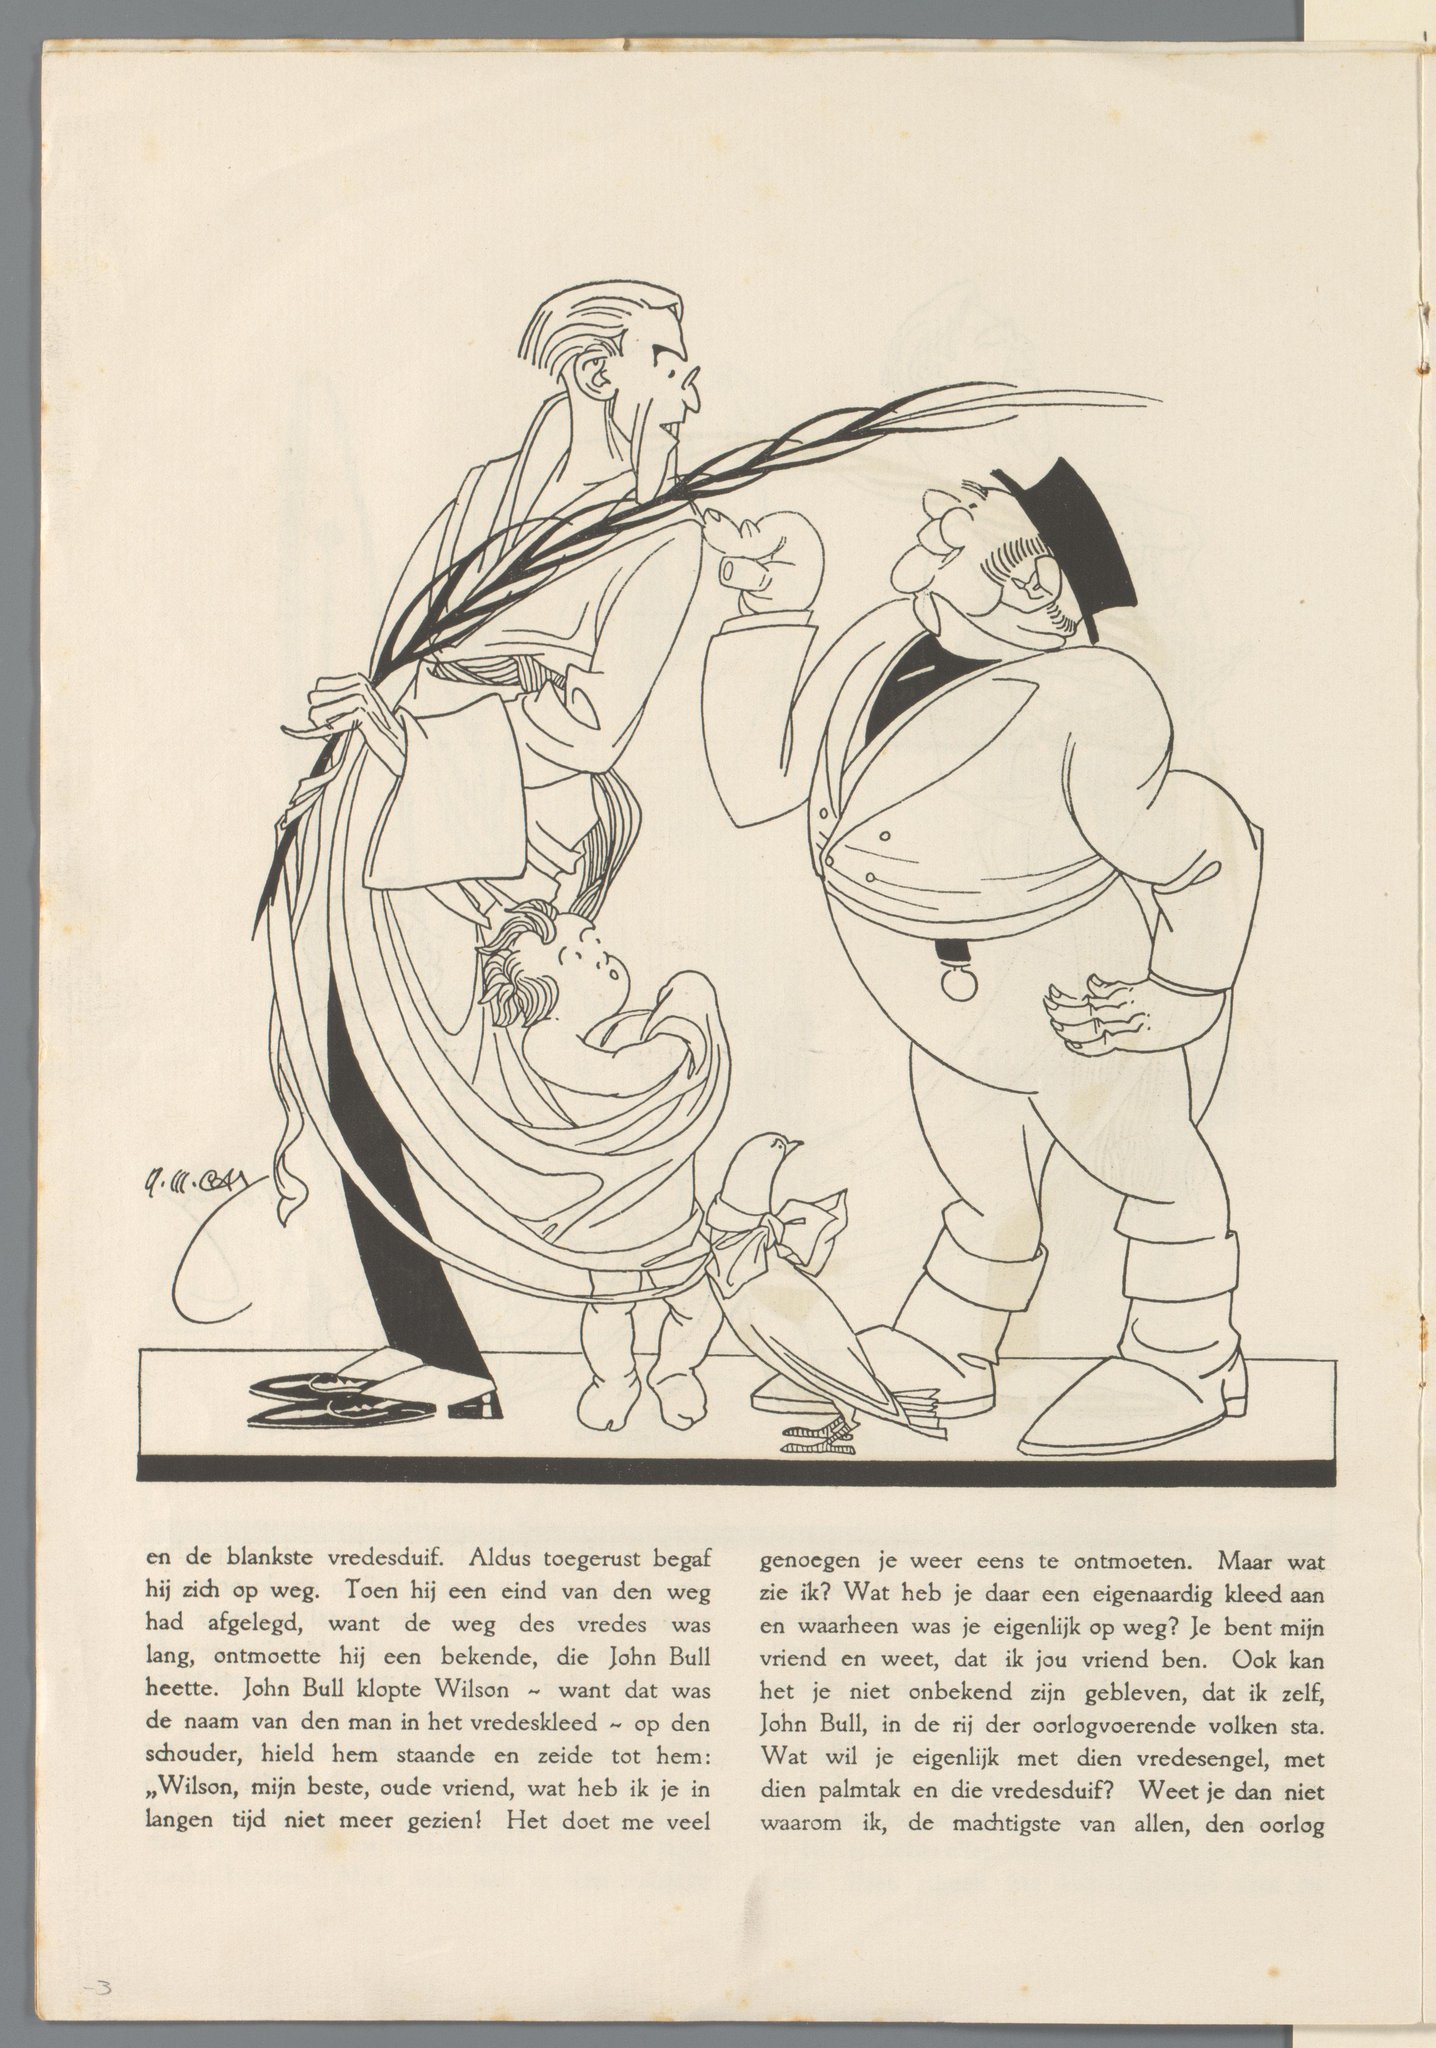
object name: book illustration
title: John Bull tikt Woodrow Wilson op de schouder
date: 1917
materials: paper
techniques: printing block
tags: president ~ head of republic, political caricatures and satires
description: Prent uit: Cay, A.M. Wilson de menschenvriend; een modern sprookje. S.l.: s.n., ca. 1917.